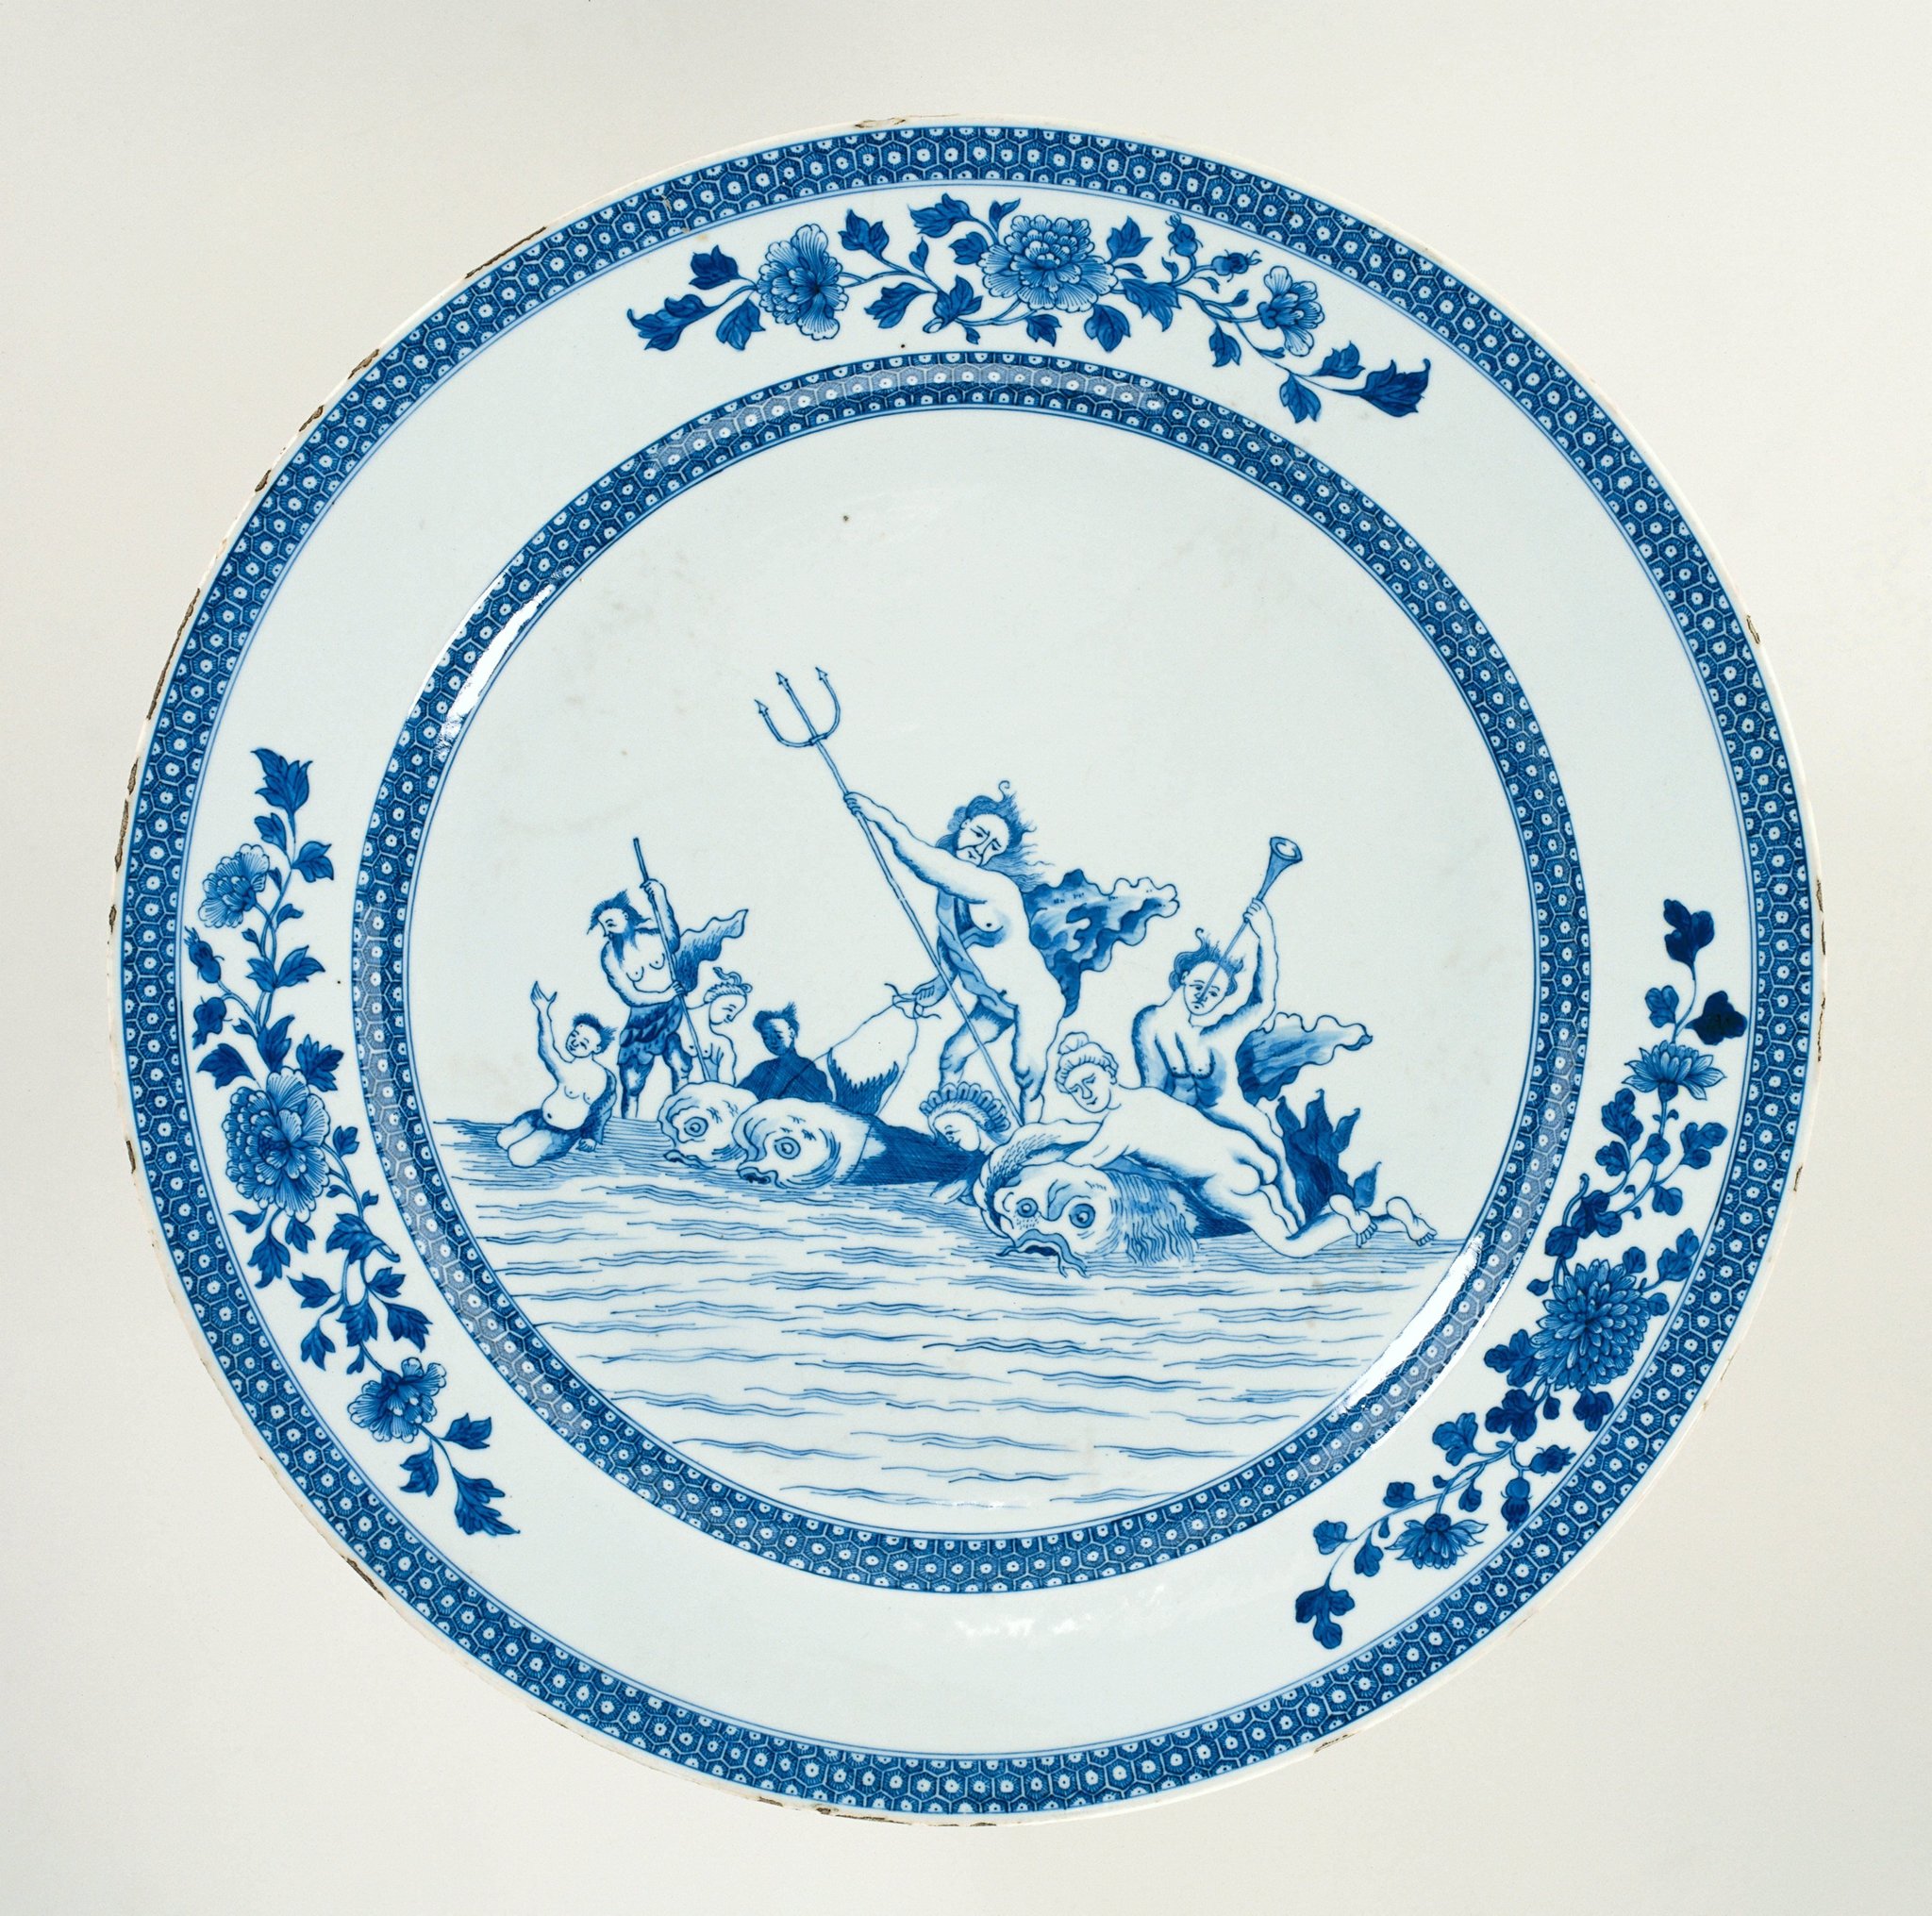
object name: platter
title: Dish with an image of Neptune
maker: Anonymous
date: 1740-1750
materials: cobalt, glaze, paint, porcelain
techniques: firing, turning, vitrification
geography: china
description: Bord op een voetring, met een platte rand. Gedecoreerd in onderglazuur blauw, met een voorstelling van Neptunus, de god van de zee, en meerminnen en meermannen. Op de rand drie bloemtakken. De voorstelling komt vanaf circa 1740 voor op porselein. Hoe populair dit onderwerp was blijkt uit een opdracht van de VOC directeuren uit 1778. Zij zonden een model van een chocoladekop met een soortgelijke voorstelling naar China zodat dit in productie kon worden genomen. De Nederlandse handelaren ter plaatse weigerden de opdracht echter, omdat Europese voorstellingen twee keer zo duur waren als Chinese voorstellingen. De voorstelling werd gemaakt naar een tekening van Frederick Bloemaert (1610-1669). Alleen onderglazuur blauwe exemplaren zijn bekend, wat opmerkelijk is. Deze werden in Jingdezhen geproduceerd en waren duurder dan de speciale bestellingen die in emailkleuren in Kanton werden geproduceerd.